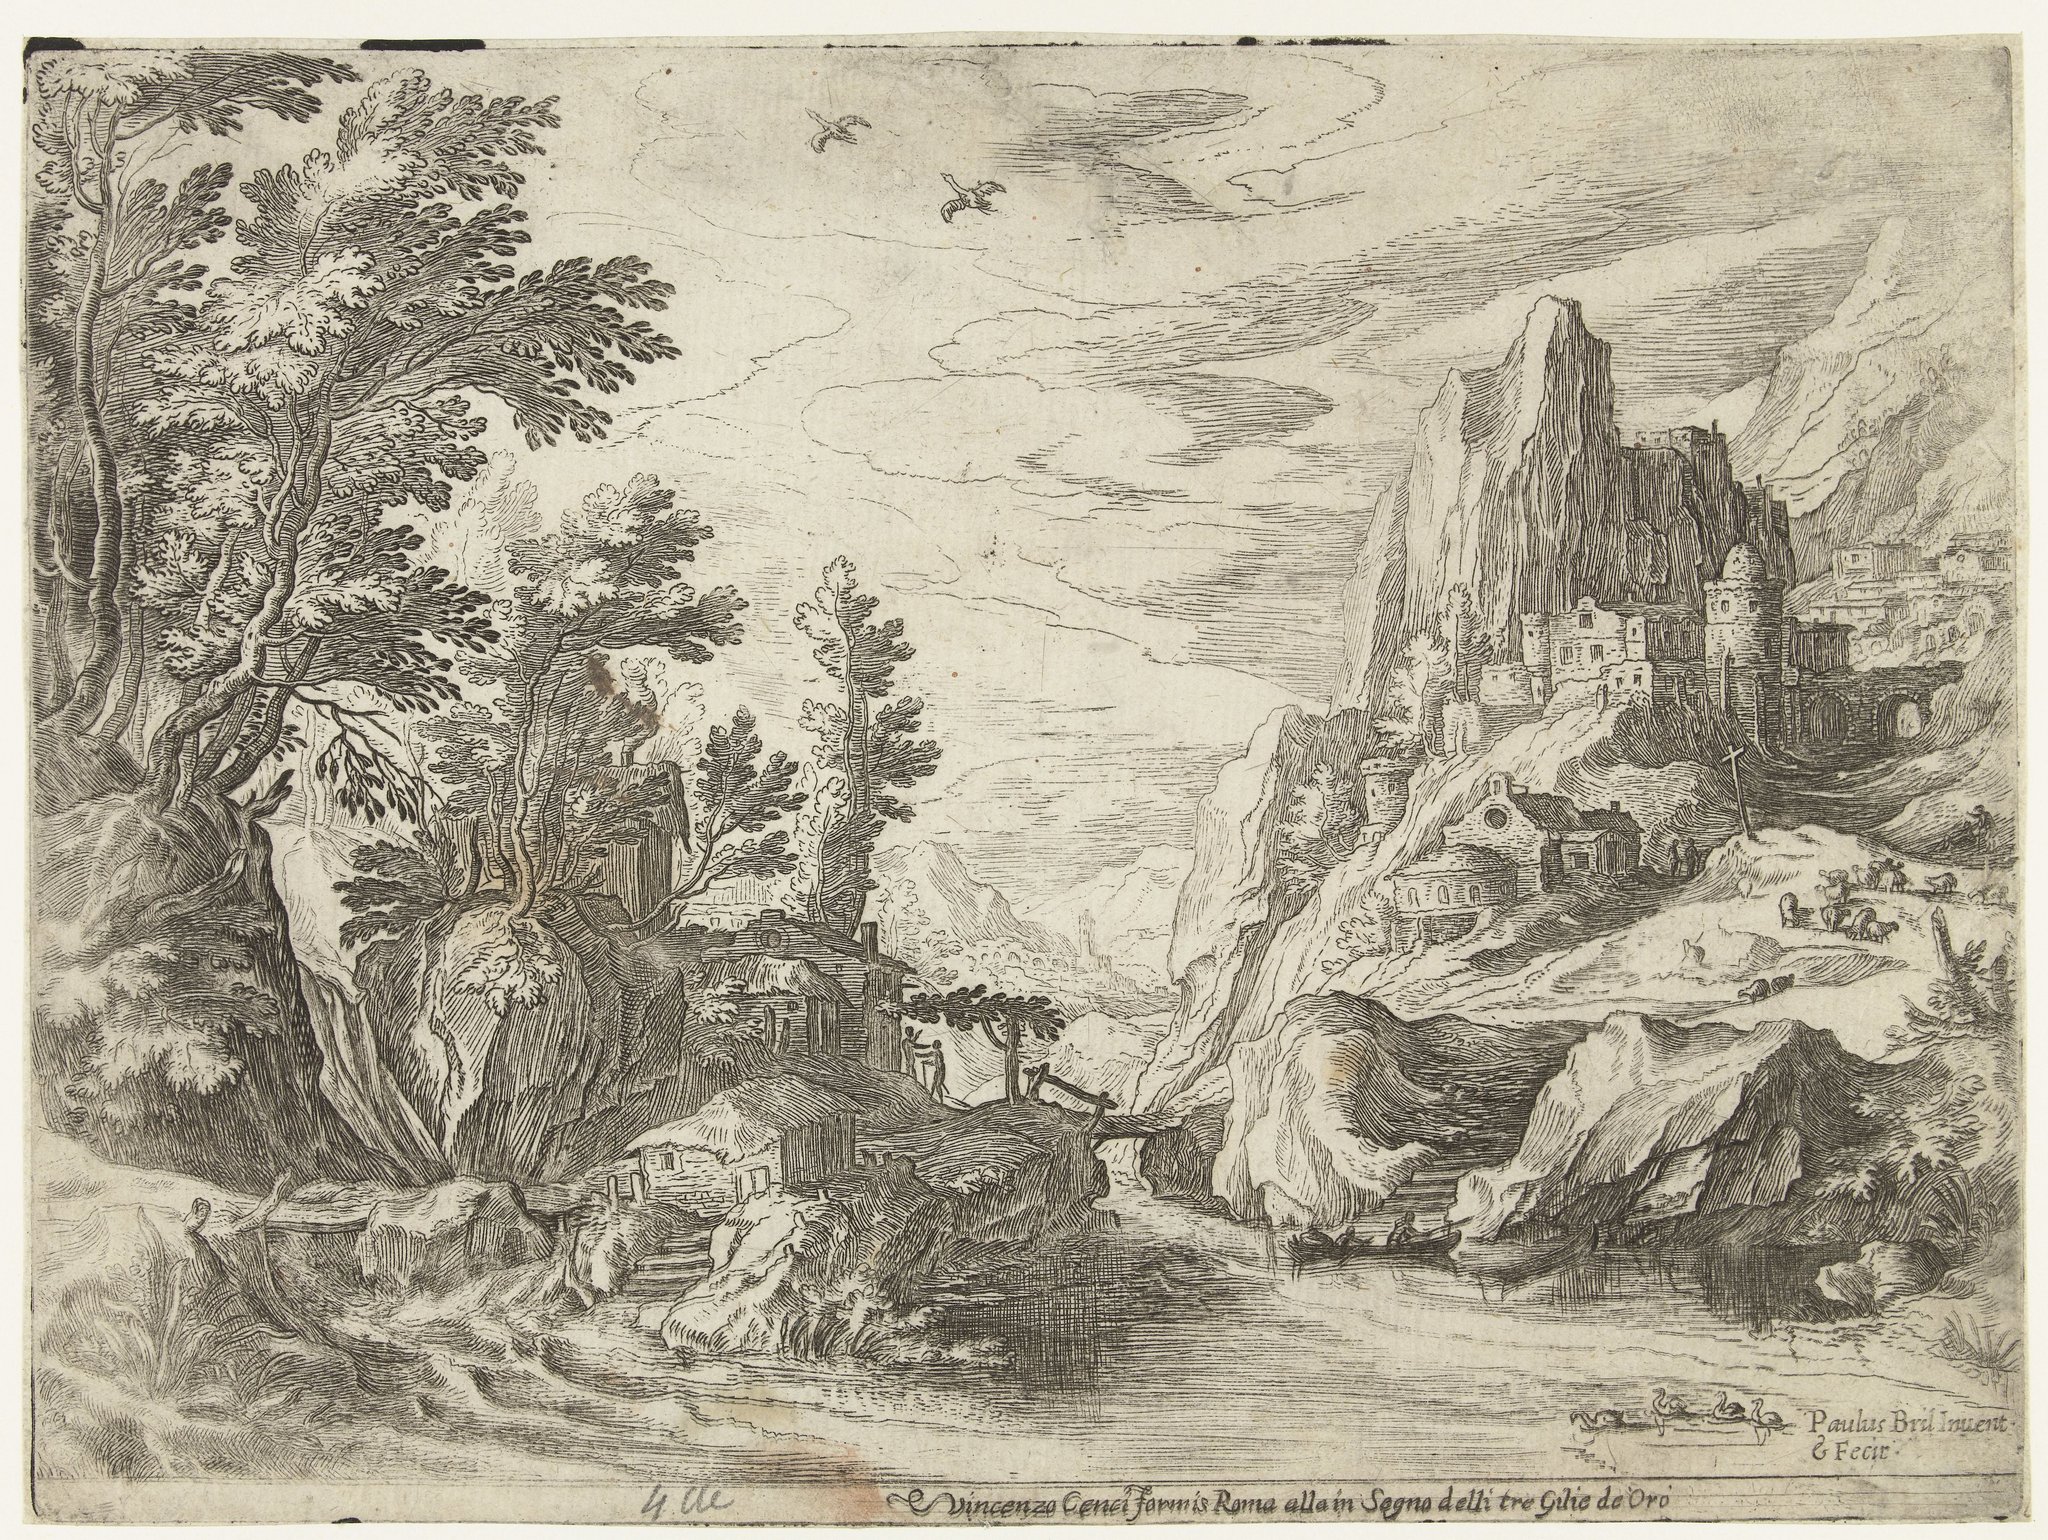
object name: print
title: Rivierlandschap in Campania met stad op rotsen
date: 1590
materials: paper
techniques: etching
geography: rome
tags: rocky coast, campania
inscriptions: collector's mark: Lugt 2228a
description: Rivierlandschap in Campania met stad op rotsen. Papier verschoven bij drukken van etsplaat waardoor vooral linksonder dubbele lijnen ontstaan.